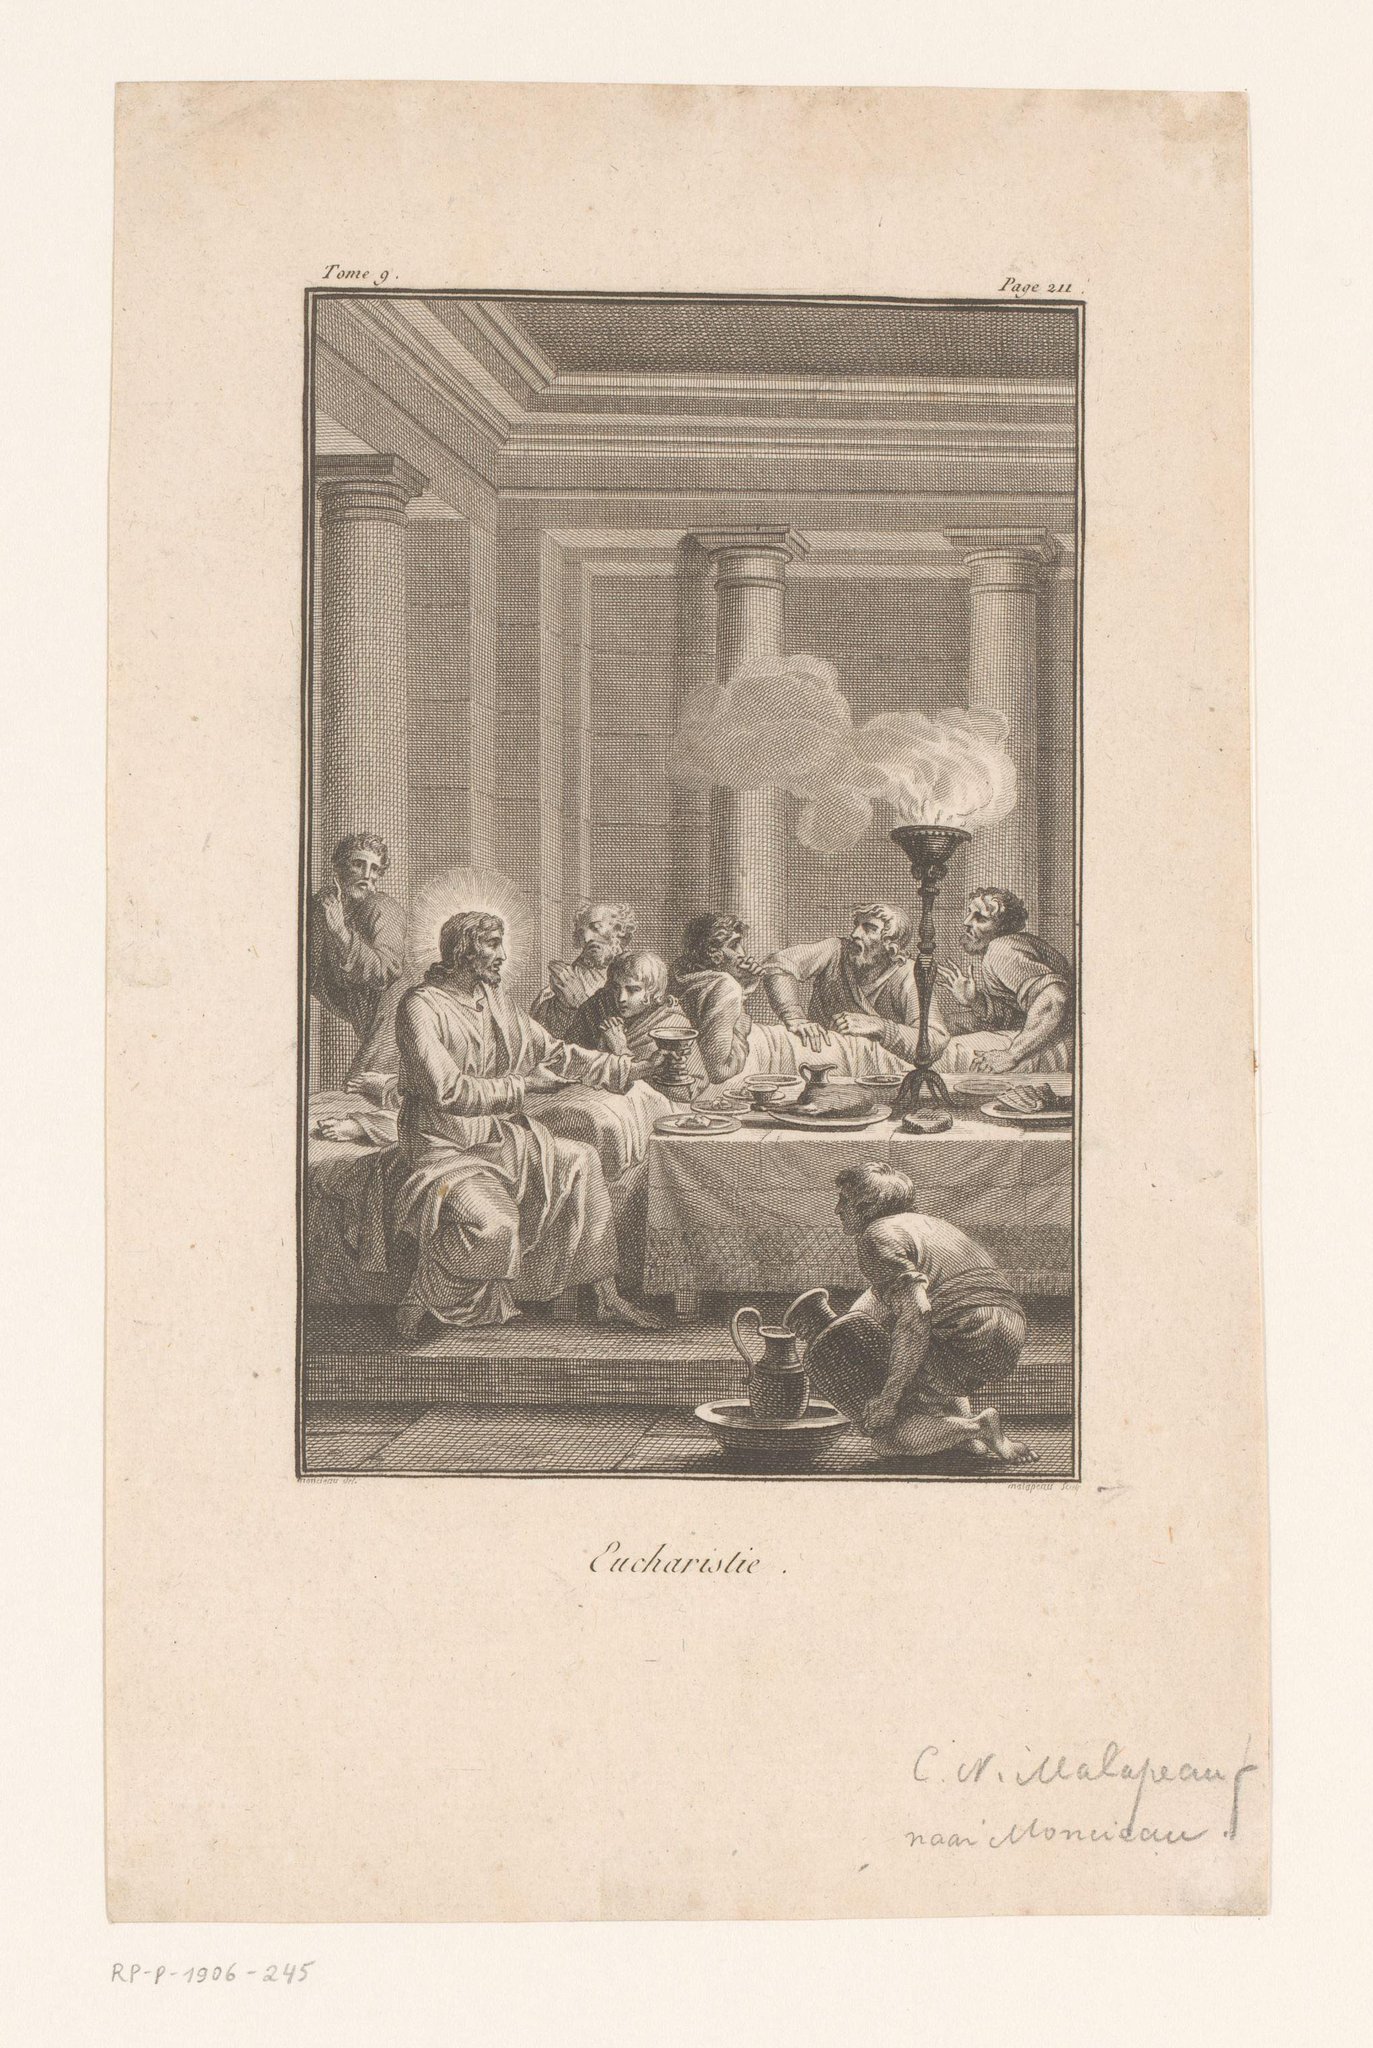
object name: book illustration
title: Eucharistie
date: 1765-1803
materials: paper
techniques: engraving, etching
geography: france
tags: the episode of the last supper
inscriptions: collector's mark: Lugt 2228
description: Prent uit: onbekend boek, dl. 9, p. 211.